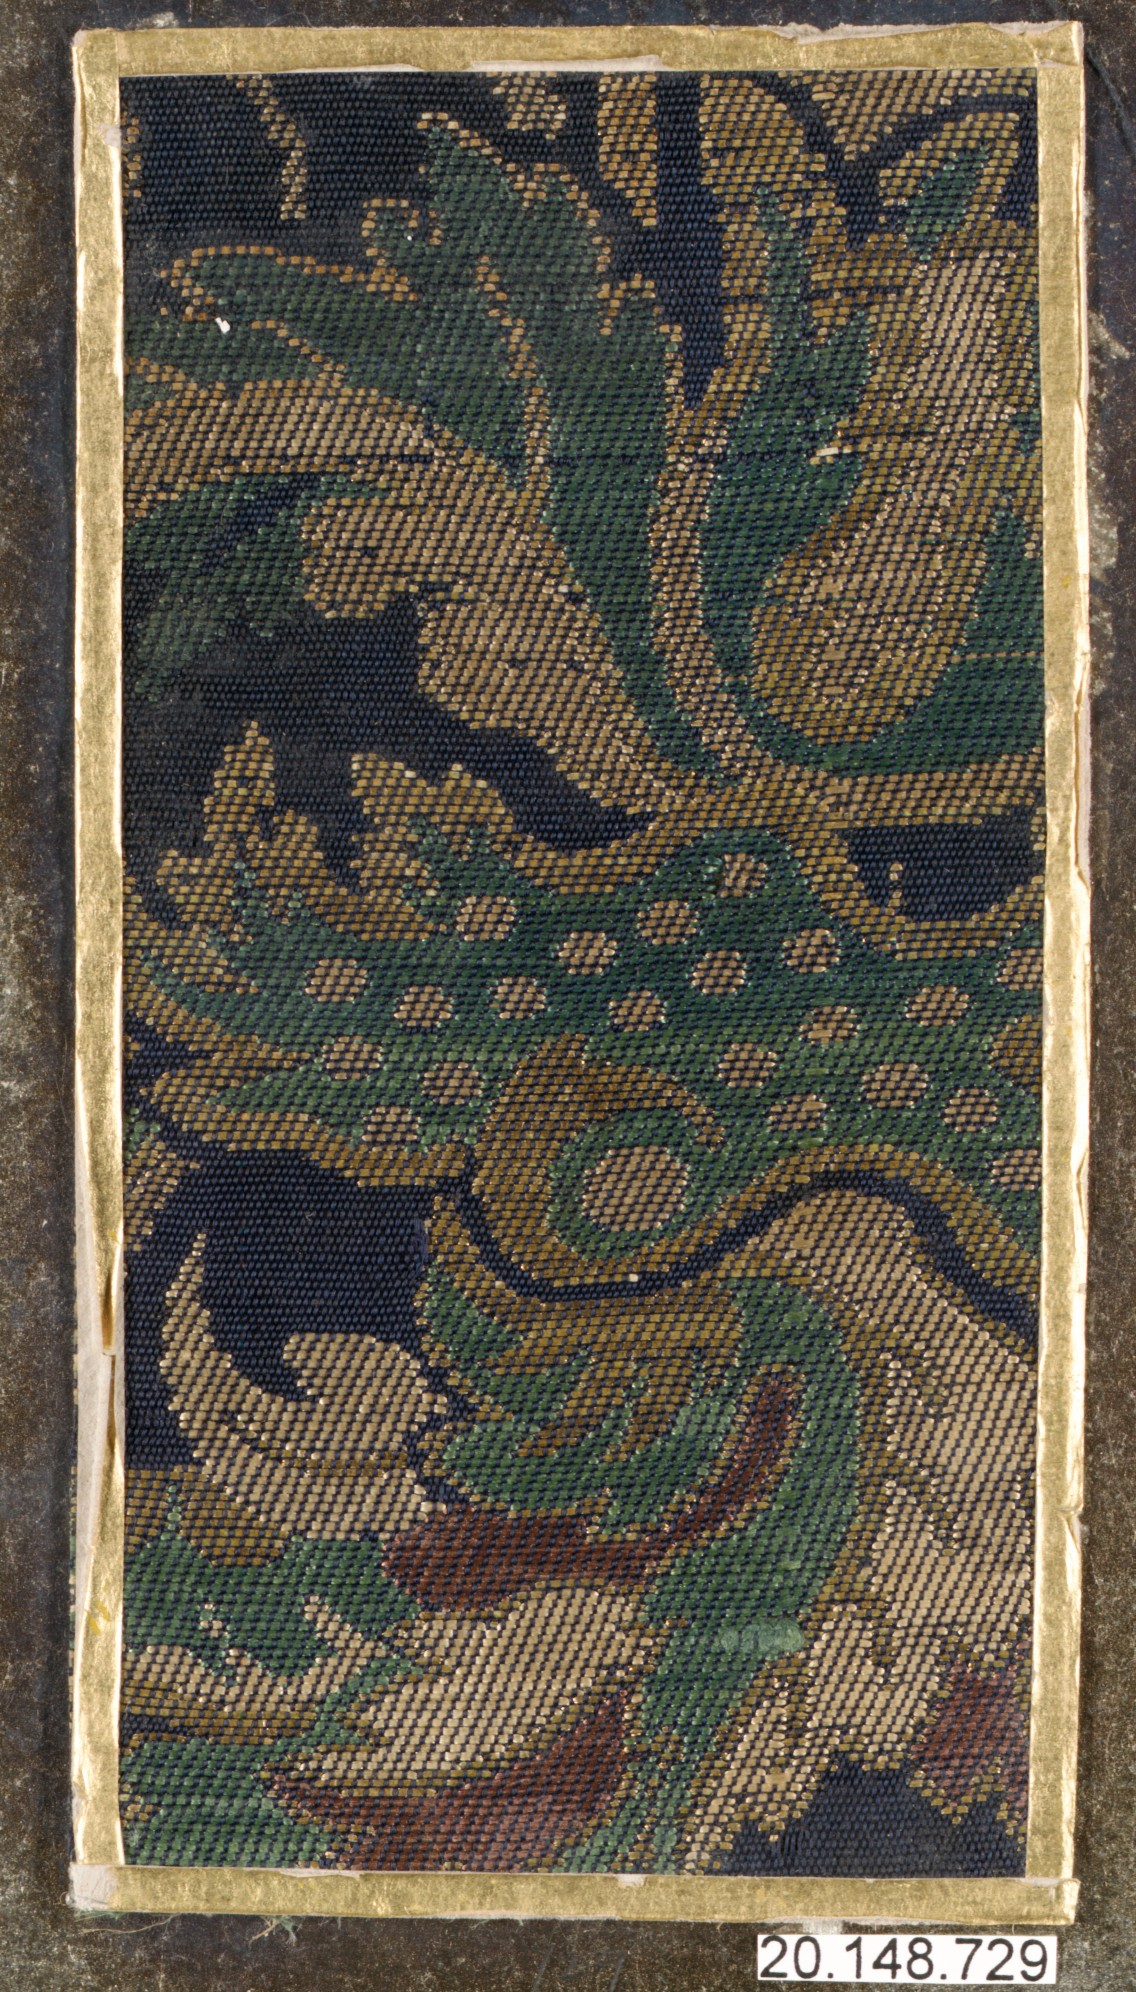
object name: piece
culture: japanese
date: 1701-1800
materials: silk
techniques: compound weave